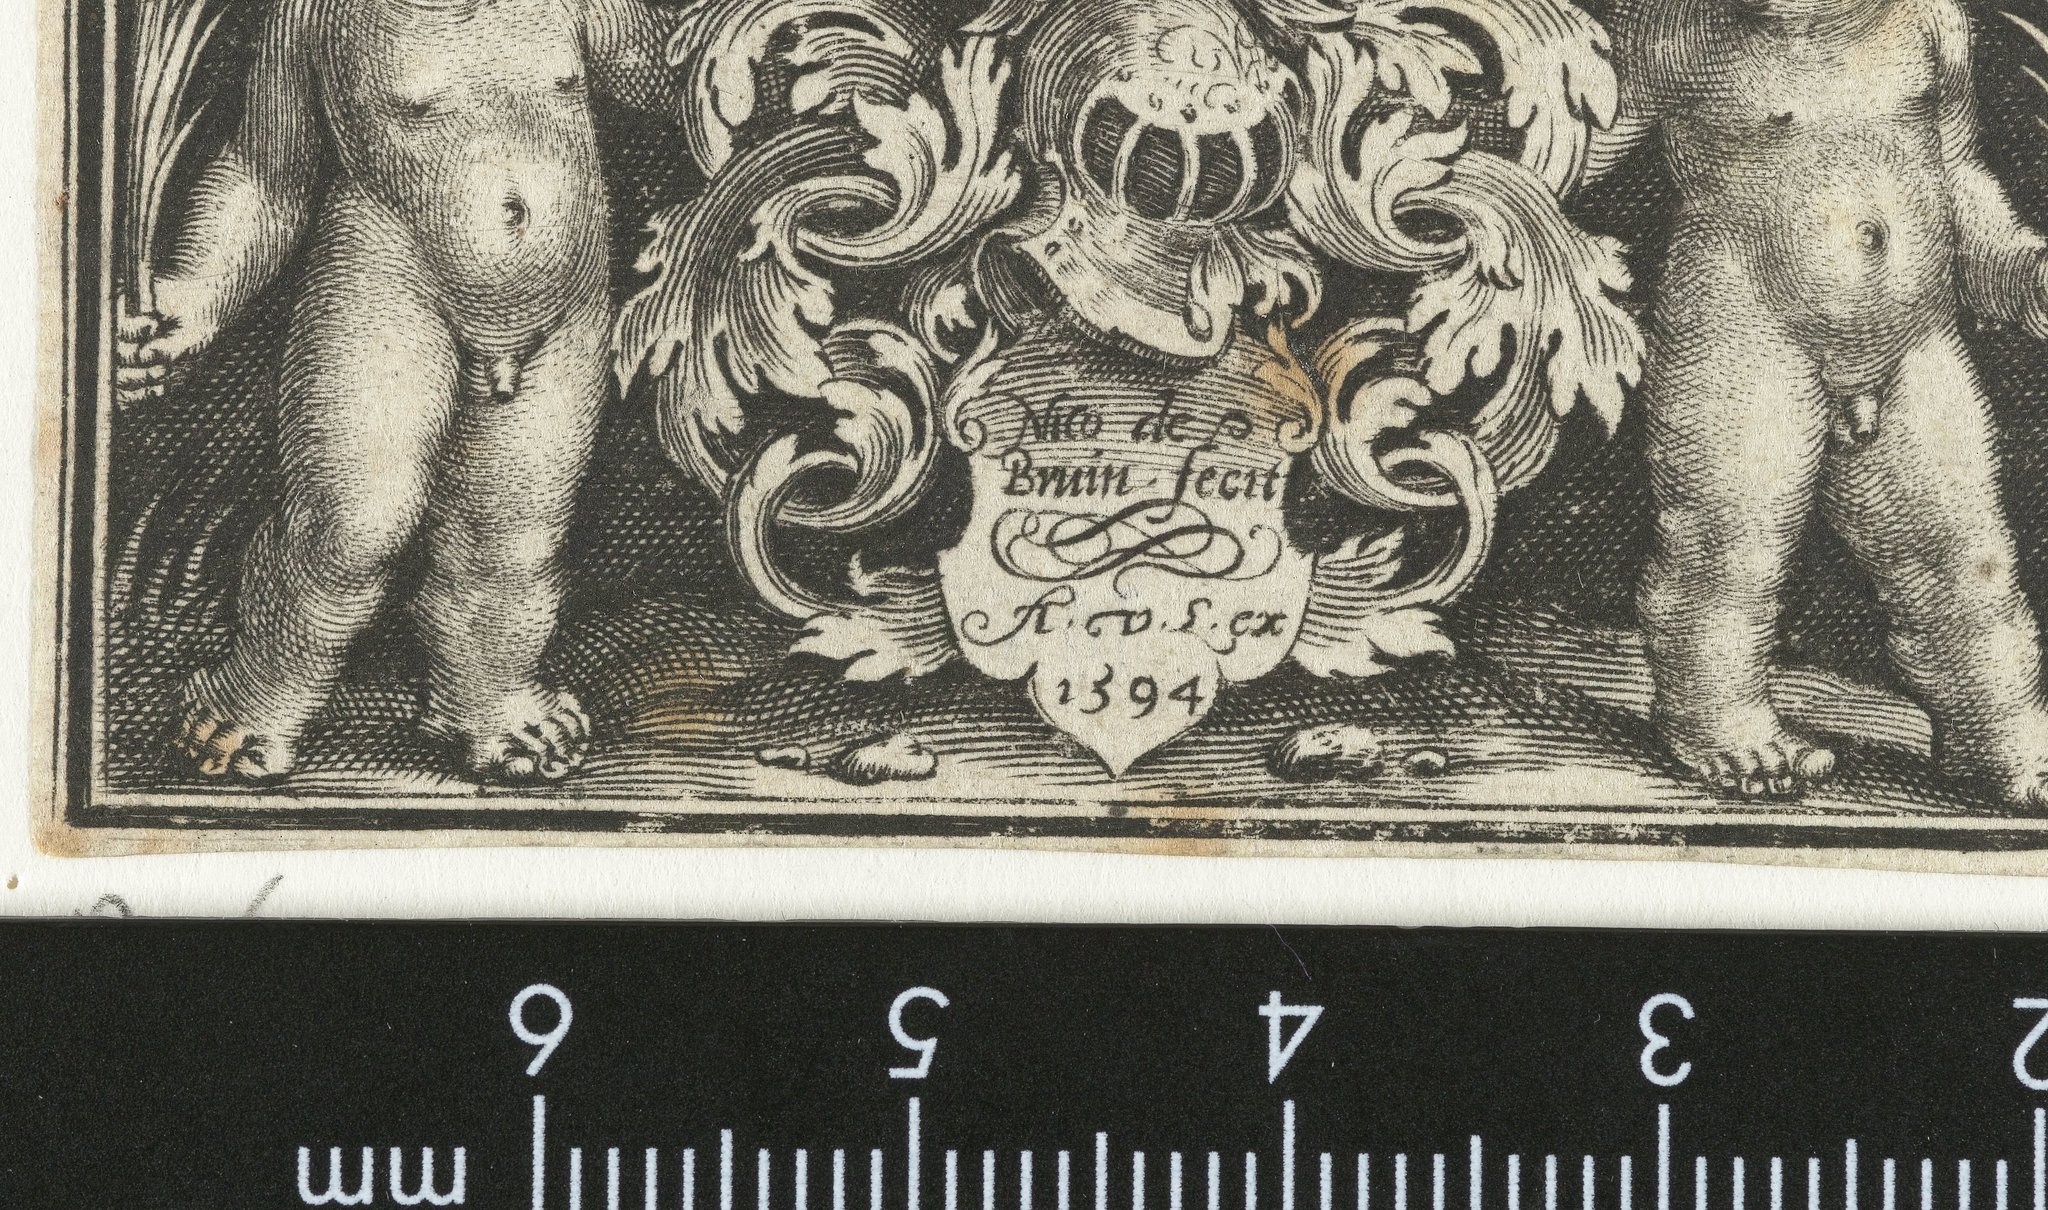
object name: print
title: Vechtende chimeras en dieren uit Aisopische fabels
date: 1594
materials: paper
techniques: engraving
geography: netherlands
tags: cupids: 'amores', 'amoretti', 'putti'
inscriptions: collector's mark: Lugt 2228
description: Prent uit serie van twaalf kleine prentjes met dieren uit fabels. R. de Rosey nr. 193. Eenzelfde serie is ook uitgegeven door Visscher (Fuhring, 1989).